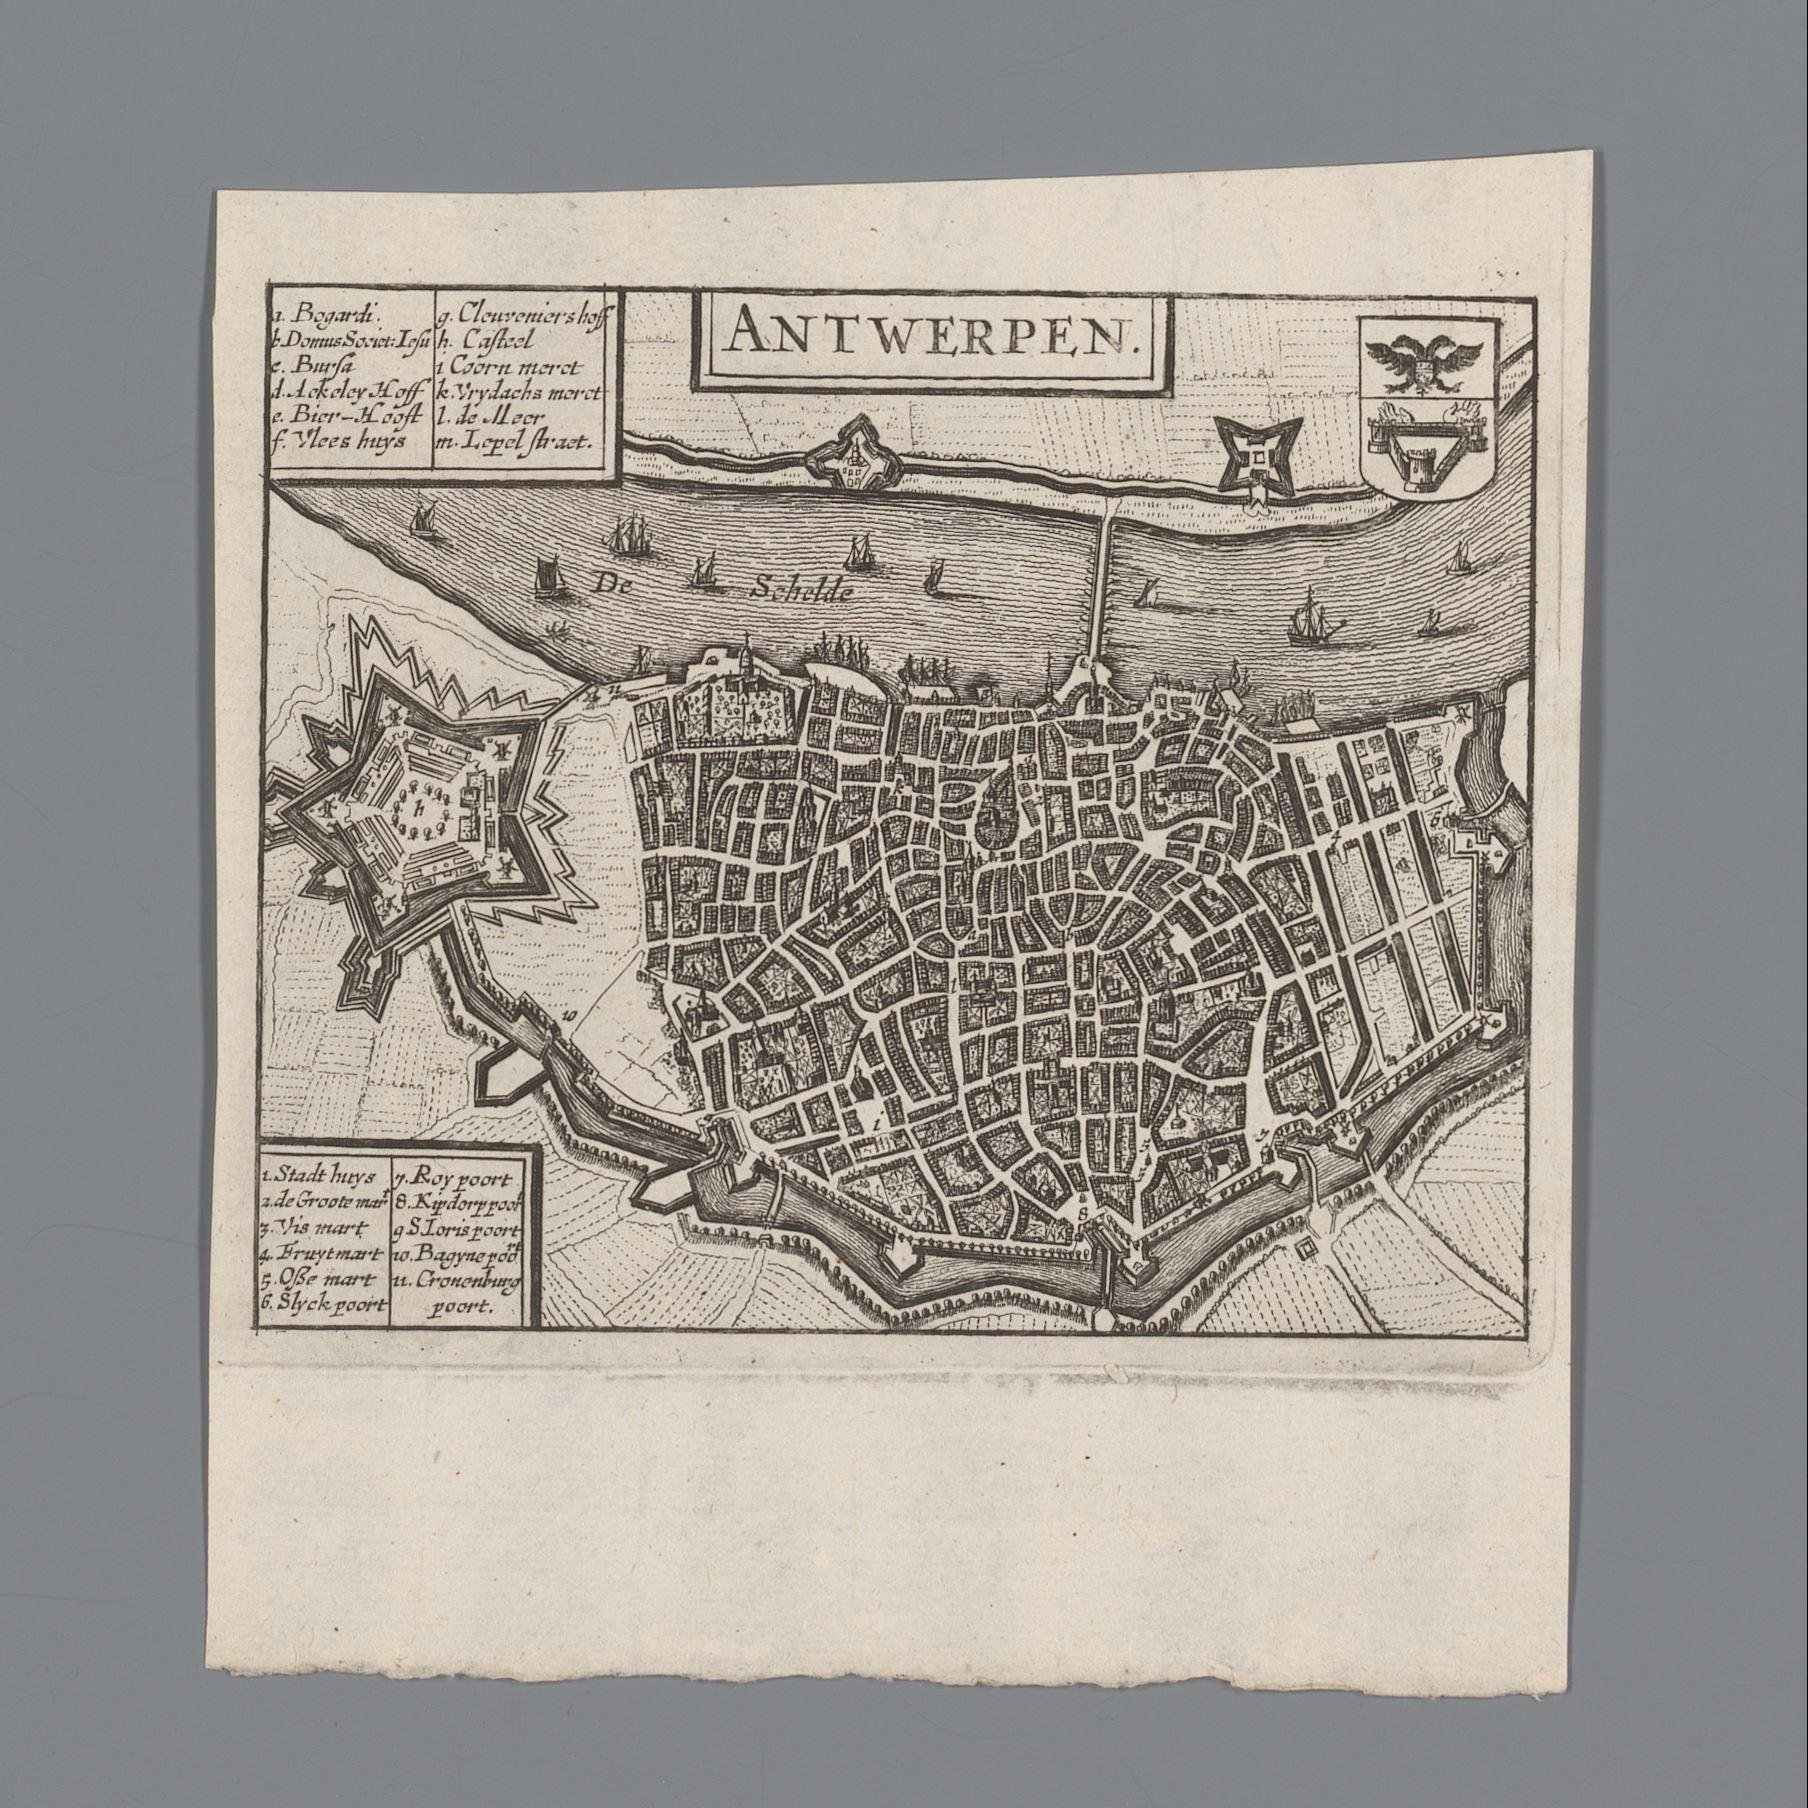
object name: area plan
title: Antwerpen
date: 1660-1662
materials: paper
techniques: etching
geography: amsterdam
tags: maps of cities, antwerp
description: Plattegrond maakt onderdeel uit van een prent met meerdere plattegronden: Alkmaar, Aalst, Amsterdam, Antwerpen, Bergen, Utrecht, Bergen op Zoom en Arnhem. Prent uit: Guicciardini, Lodovico. Belgicae sive Inferioris Germaniae (...). Amsterdam: Jacob van Meurs, 1660.